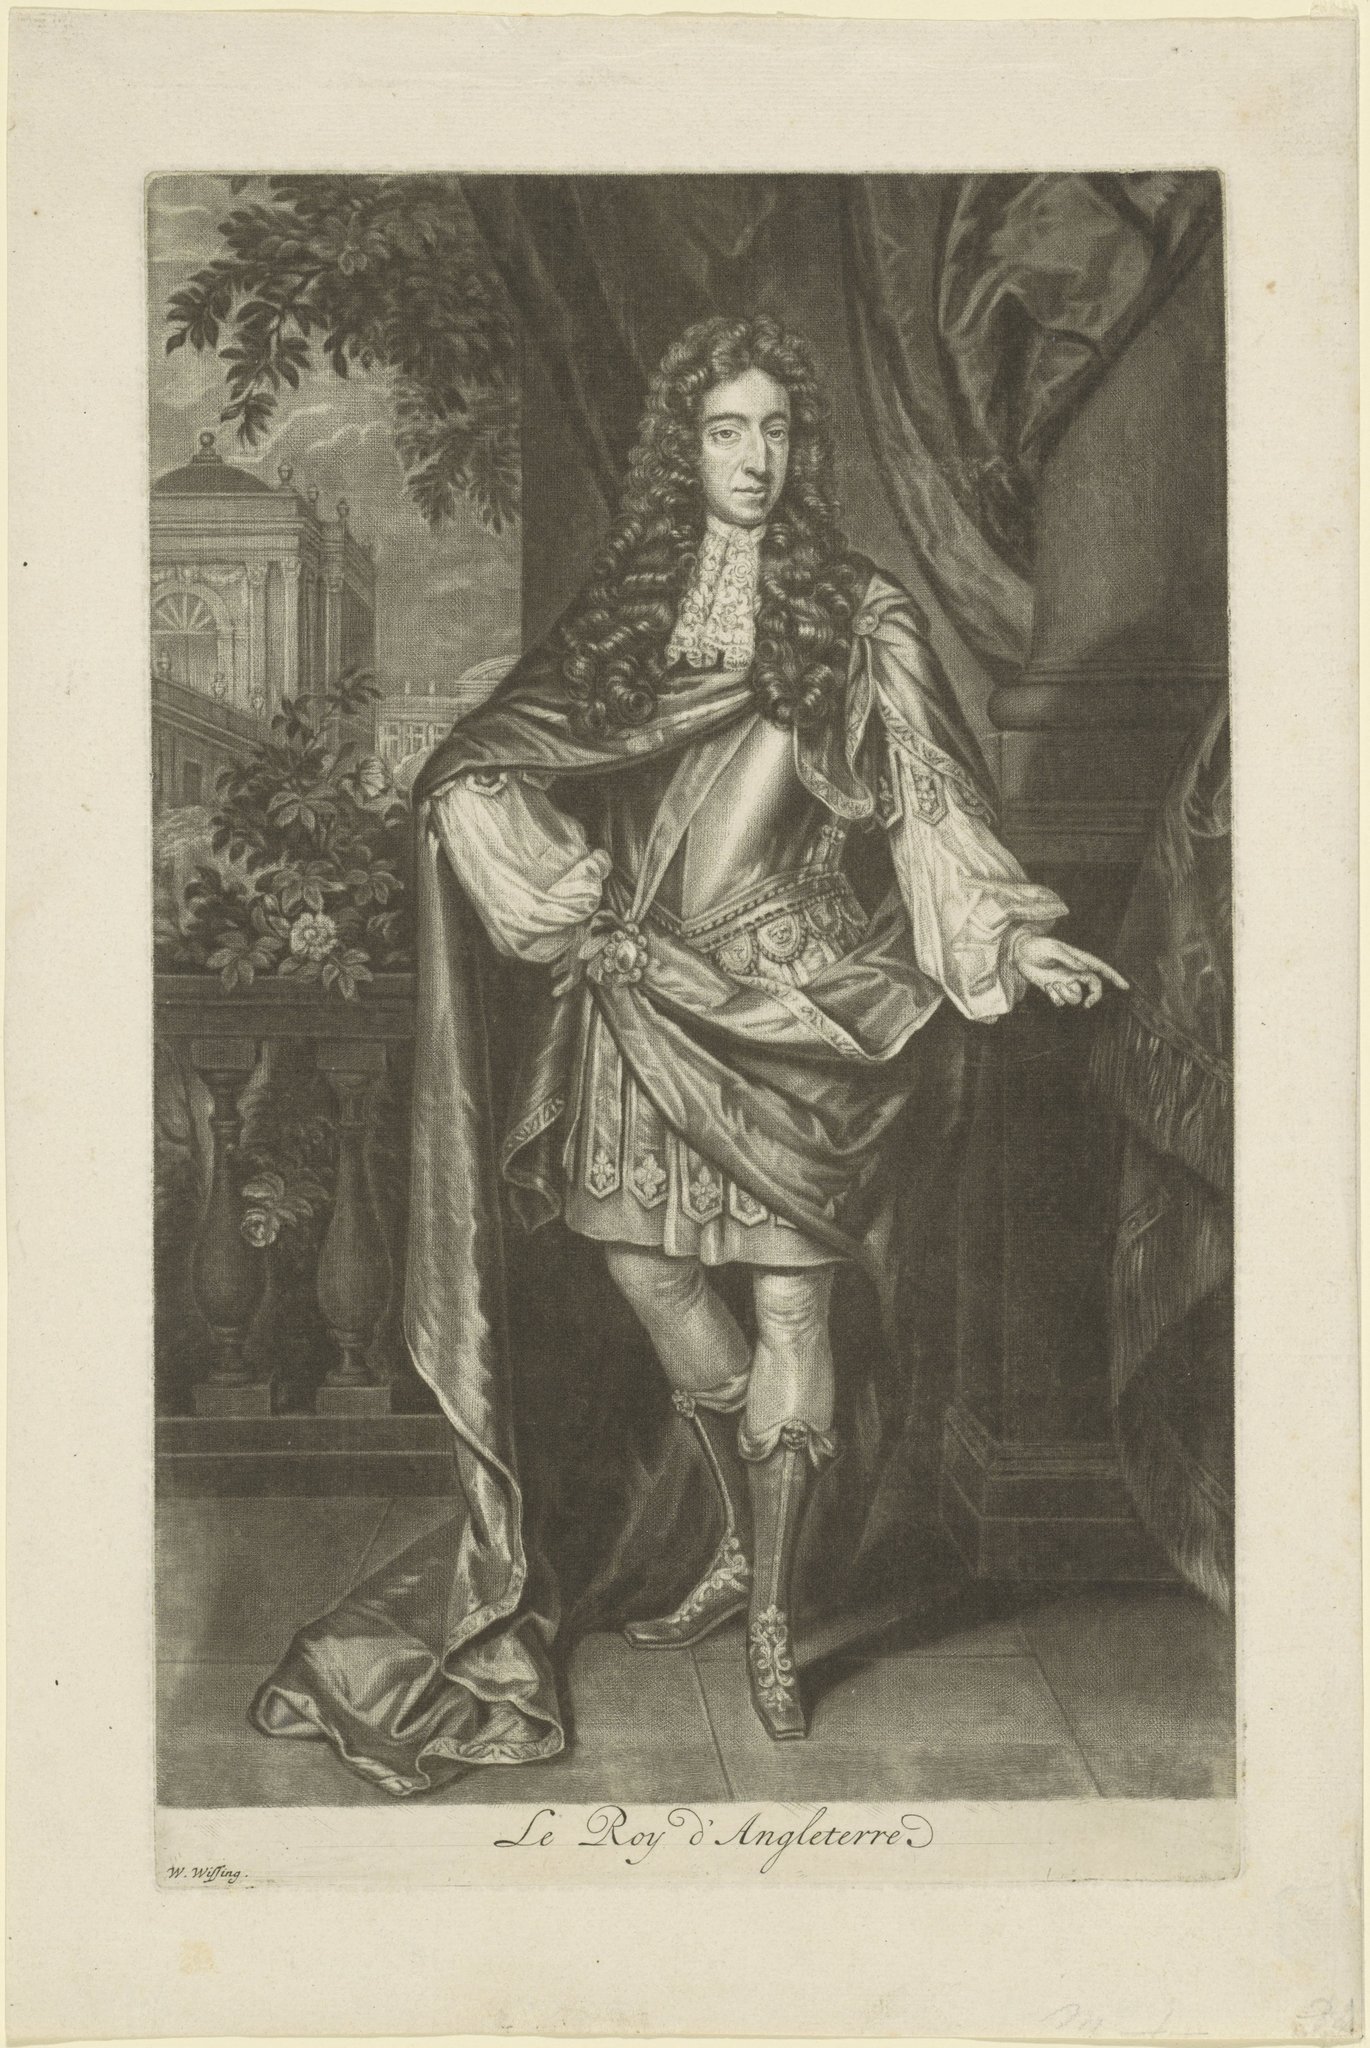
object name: print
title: Portret van Willem III, prins van Oranje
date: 1688-1749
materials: paper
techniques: mezzotint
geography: low countries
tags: the hague, william iii (prince of orange and king of england, scotland, and ireland)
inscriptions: collector's mark: Lugt 963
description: Portret van Willem III. Zijn rechterhand op zijn heup en zijn linkerhand wijst ergens naar. Op de achtergrond een balustrade, een rozenstruik en grote gebouwen. In de ondermarge zijn titel in het Frans.